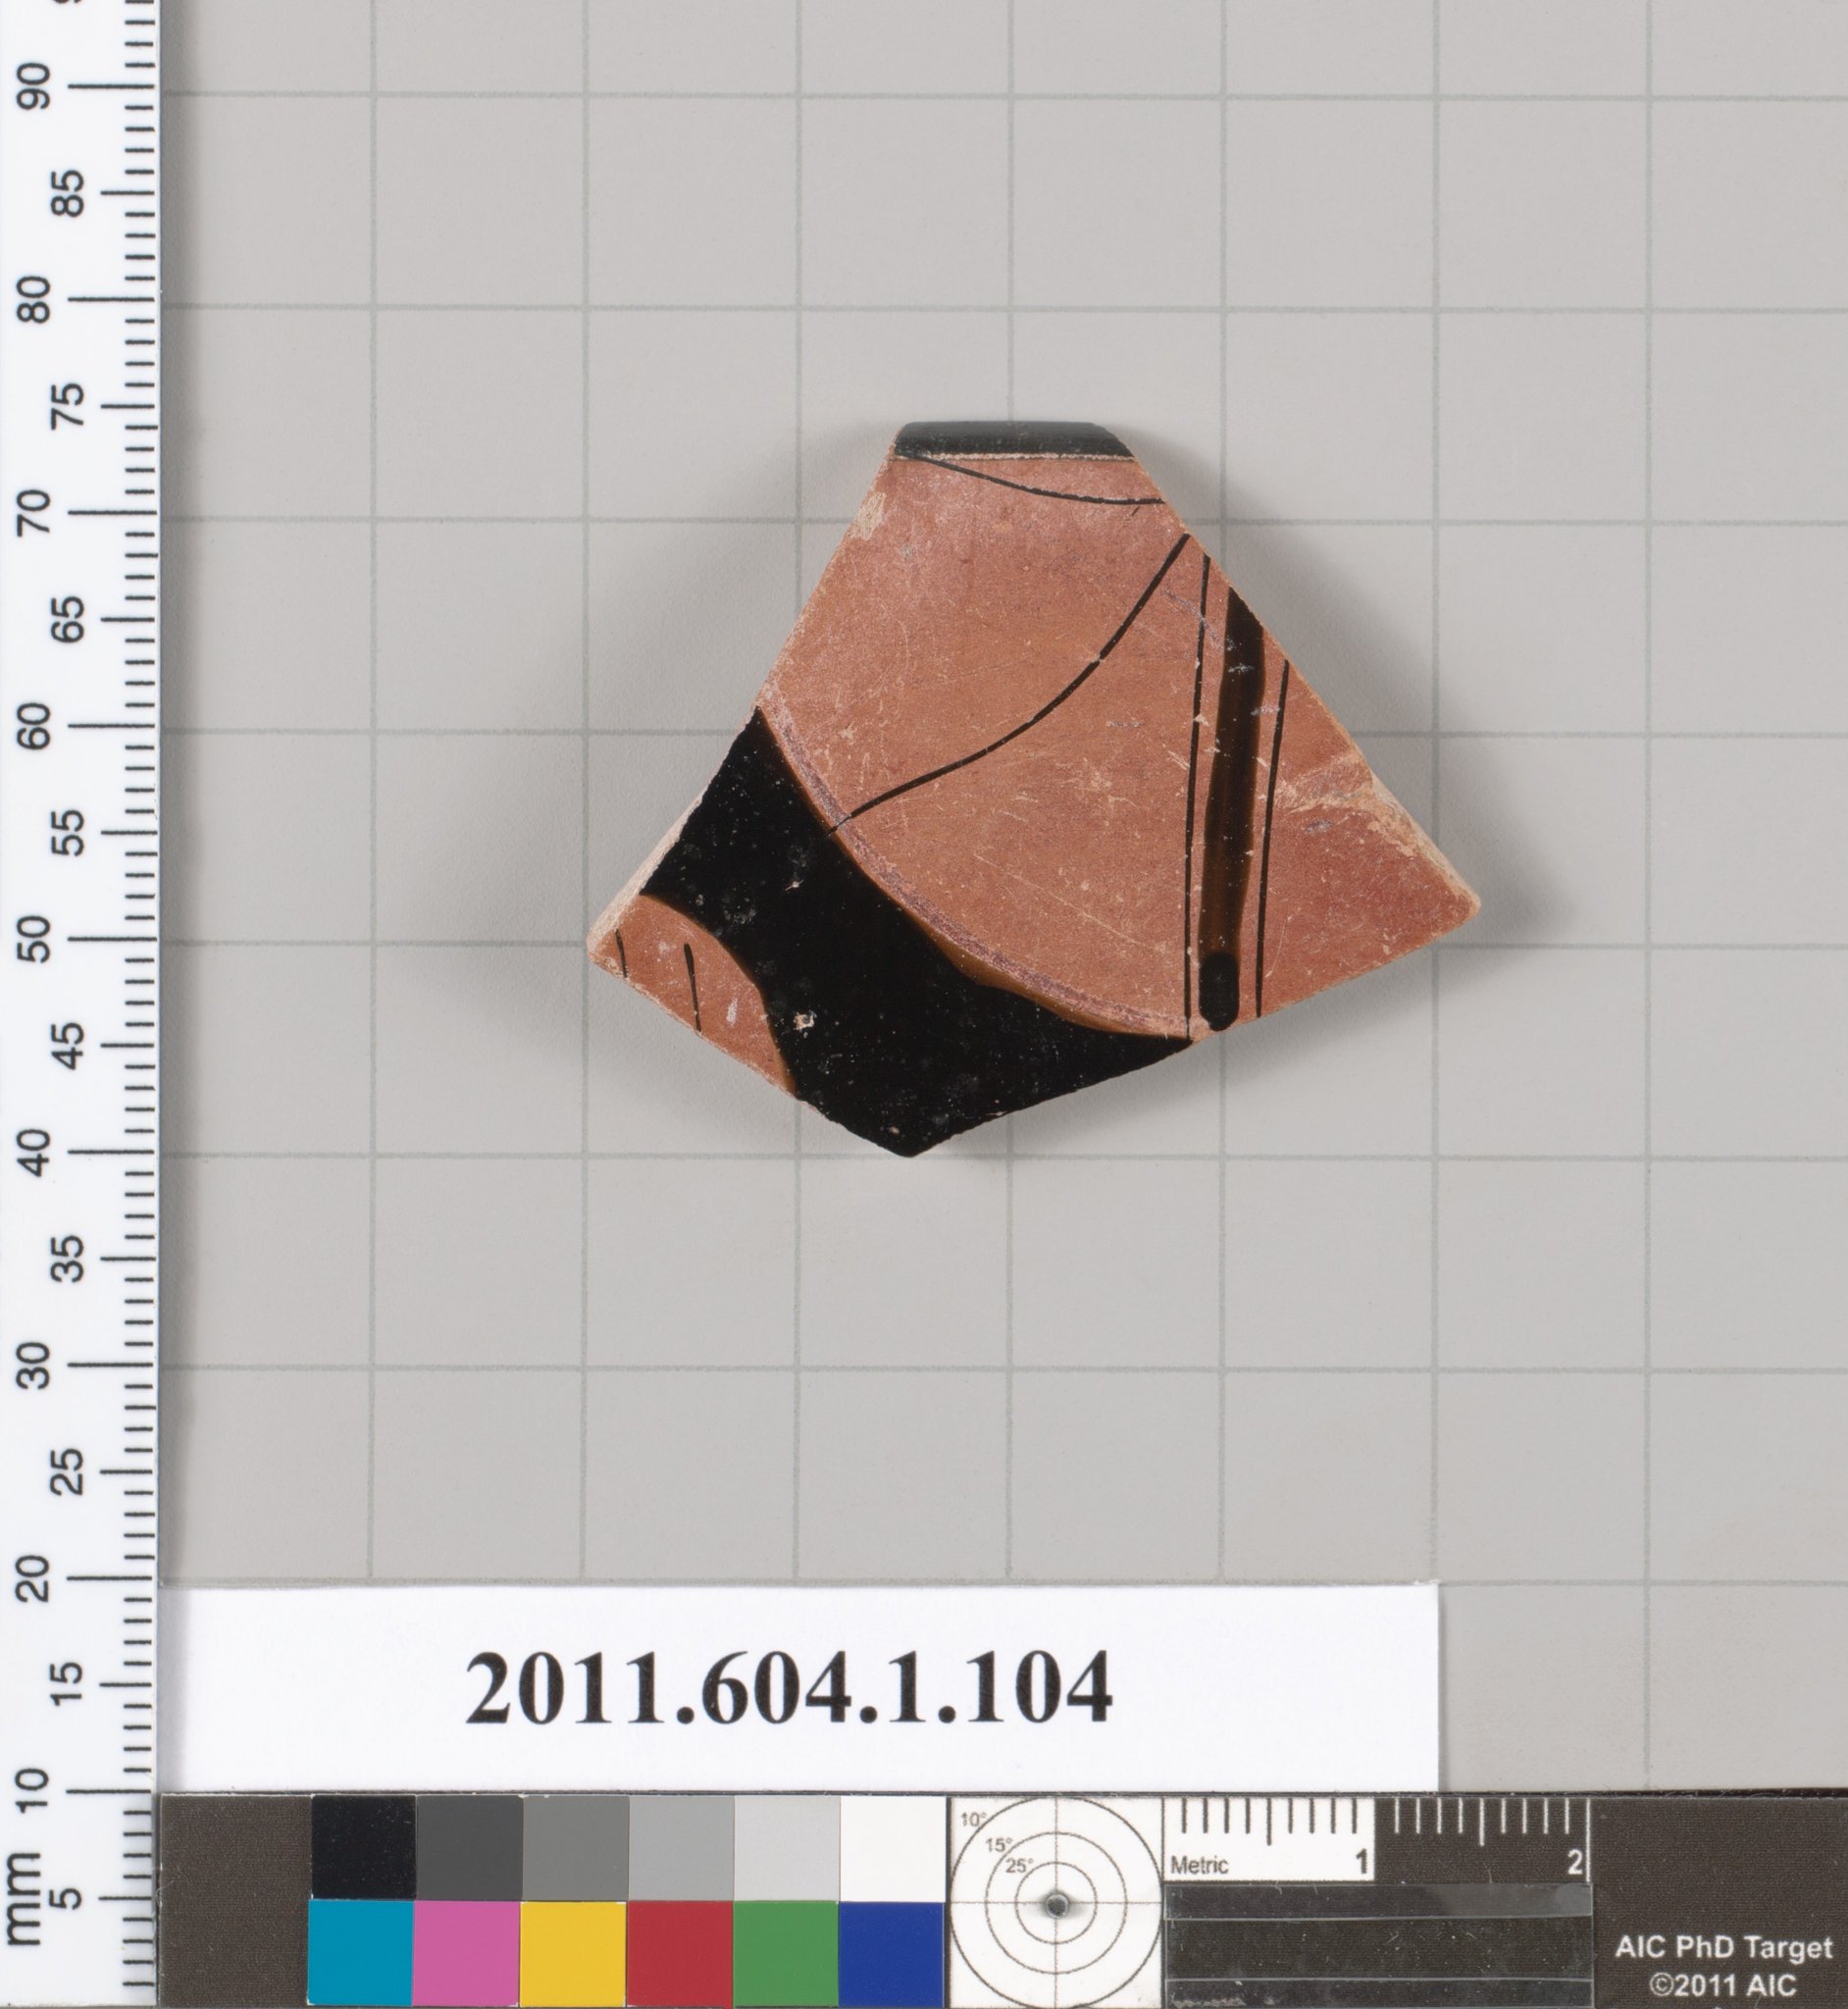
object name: kylix fragment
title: Terracotta fragment of a kylix (drinking cup)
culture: greek, attic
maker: splanchnopt painter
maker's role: artist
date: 470-450 BCE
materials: terracotta